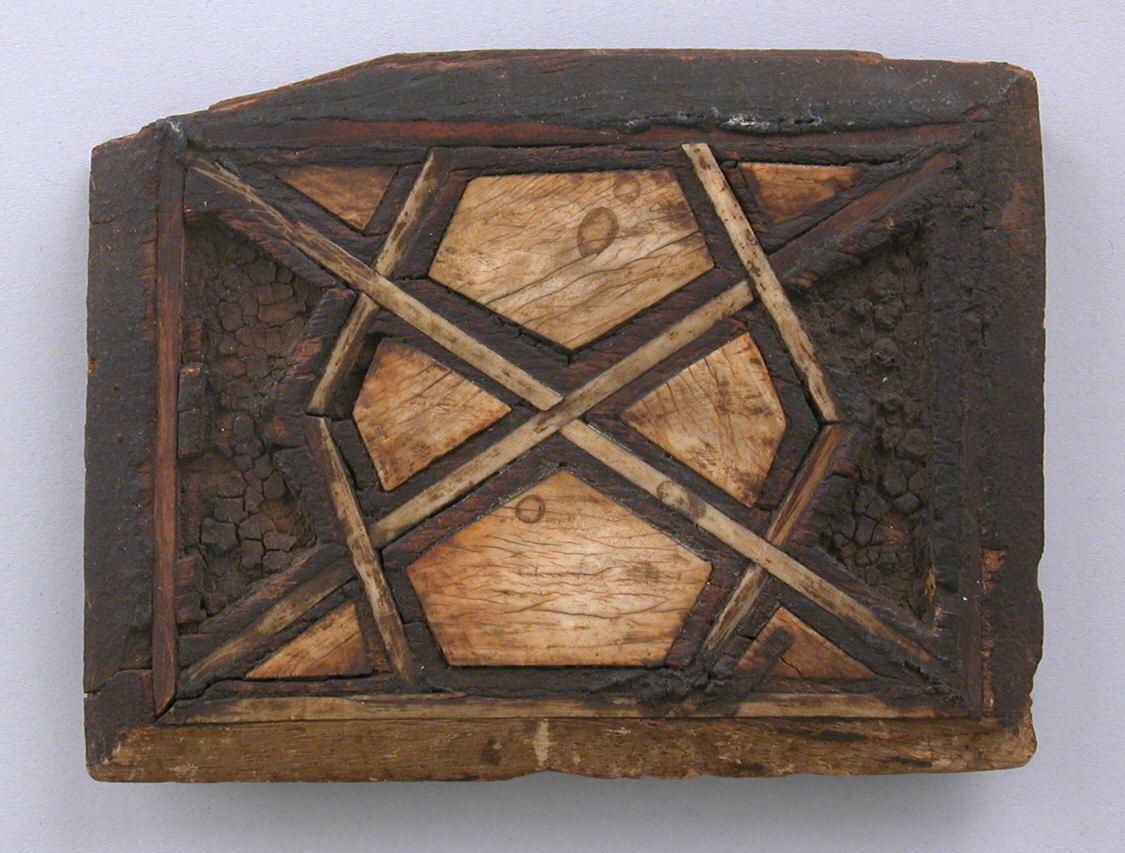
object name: panel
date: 1301-1500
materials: ivory, wood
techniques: carving, inlay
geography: egypt